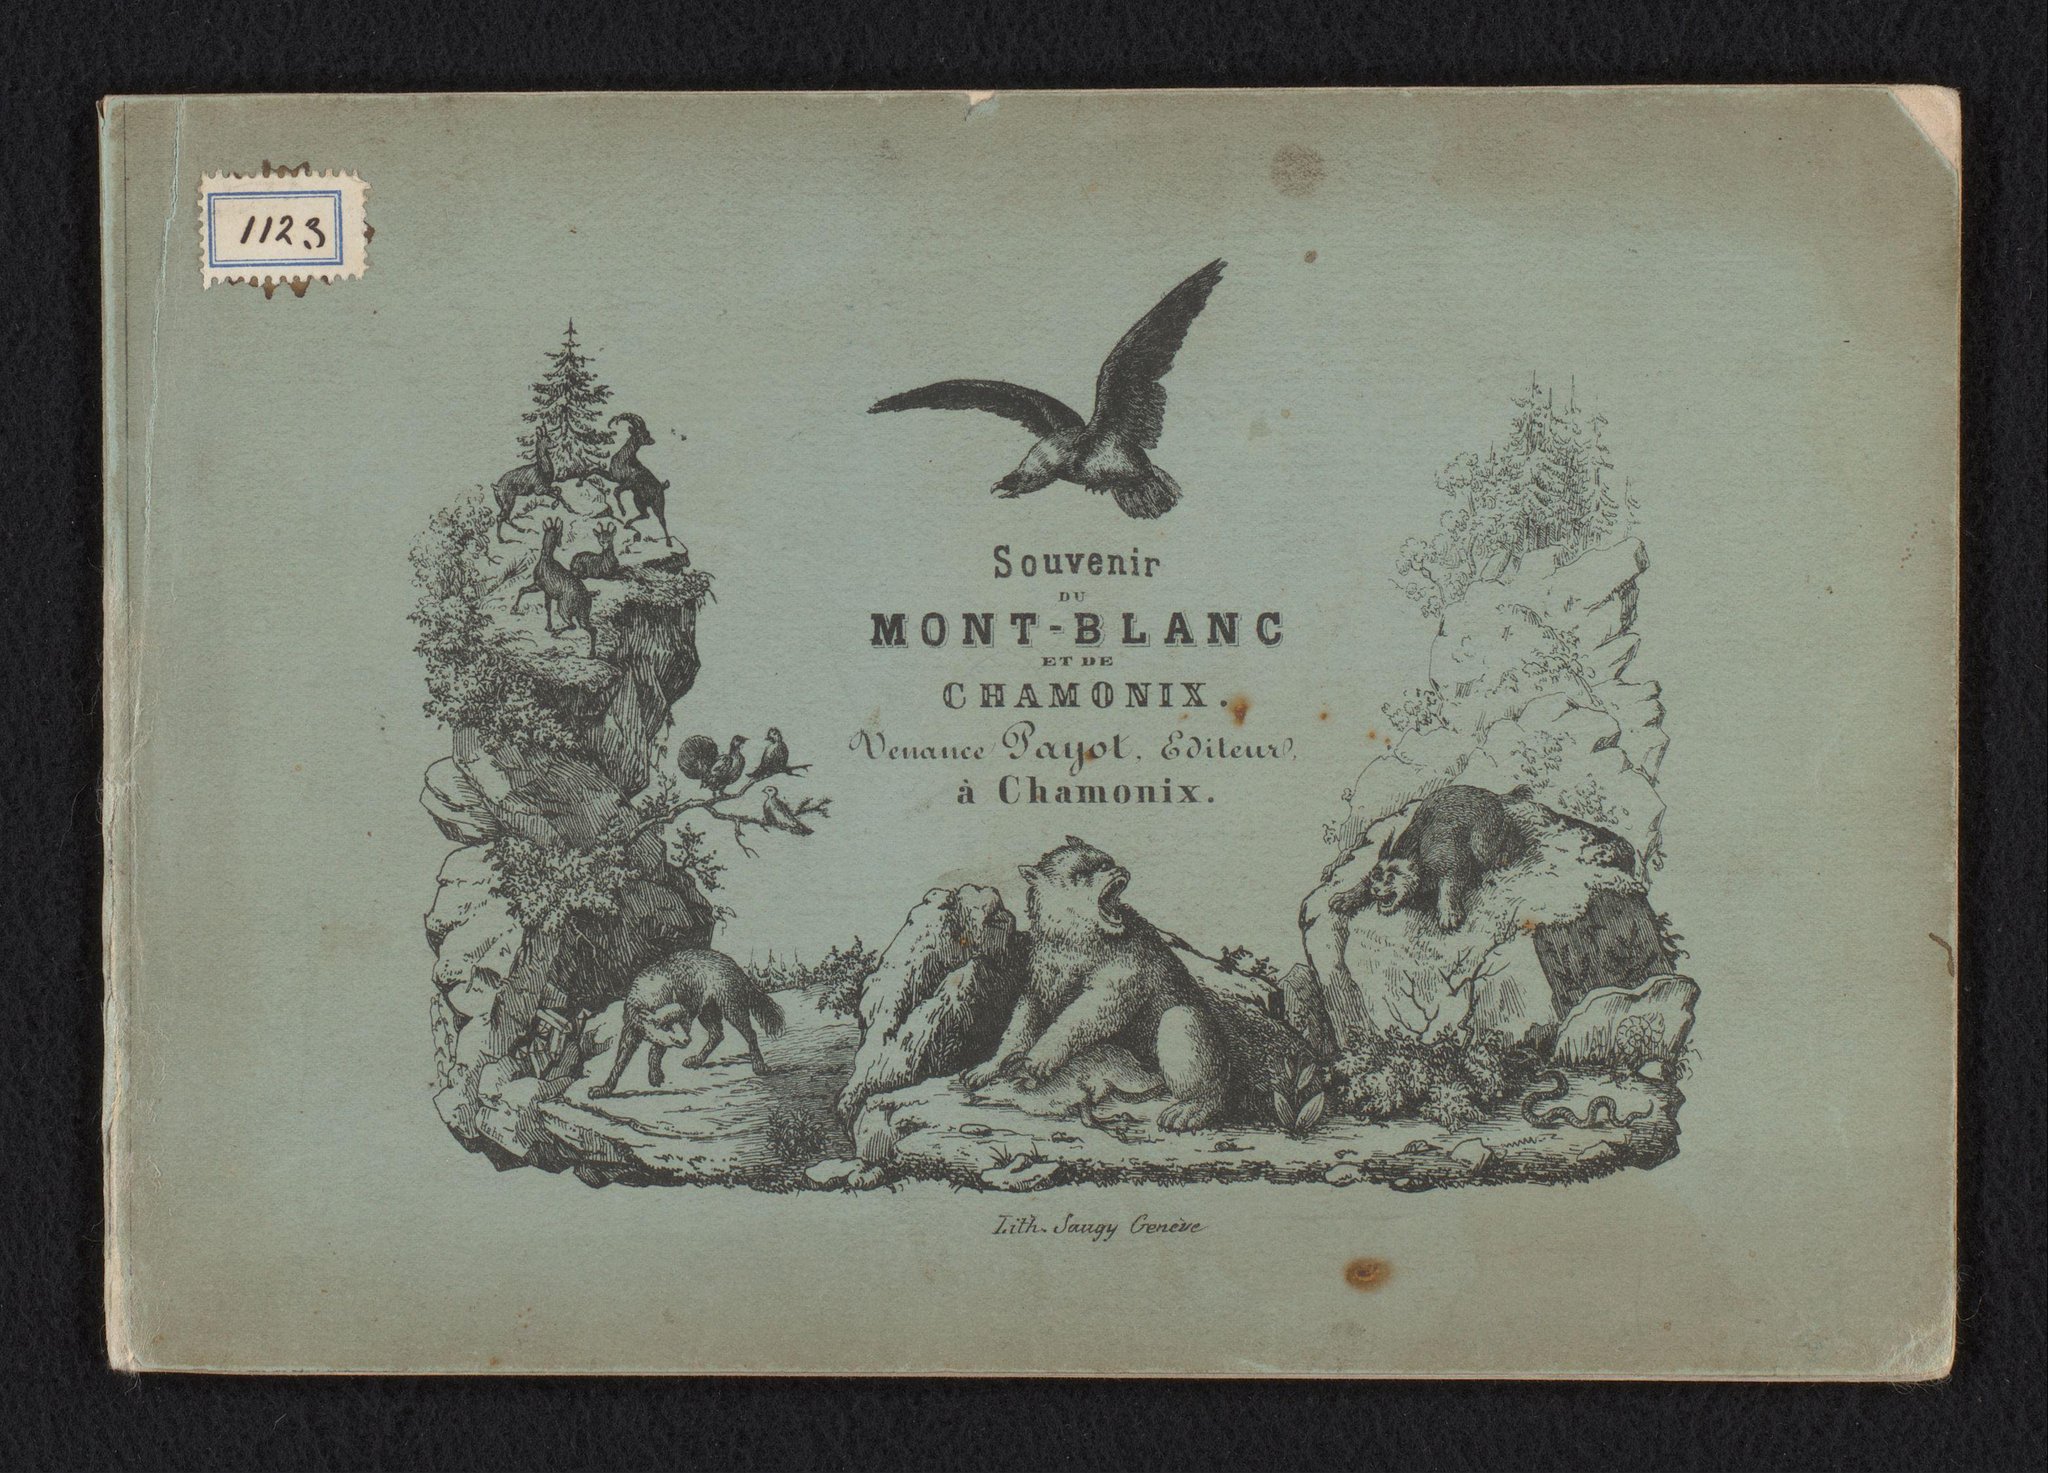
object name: print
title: Herinnering aan Chamonix-Mont-Blanc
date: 1858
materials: paper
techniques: lithograph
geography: chamonix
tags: hoofed animals: chamois, hoofed animals: ibex, beasts of prey, predatory animals: bear, beasts of prey, predatory animals: lynx, rocks, beasts of prey, predatory animals: wolf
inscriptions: number: ‘4/1978’, number: ‘1123’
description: De omslag is versierd met dieren die in het Mont Blancmassief leven, zoals gemzen, een steenbok, een wolf, een beer en een lynx.